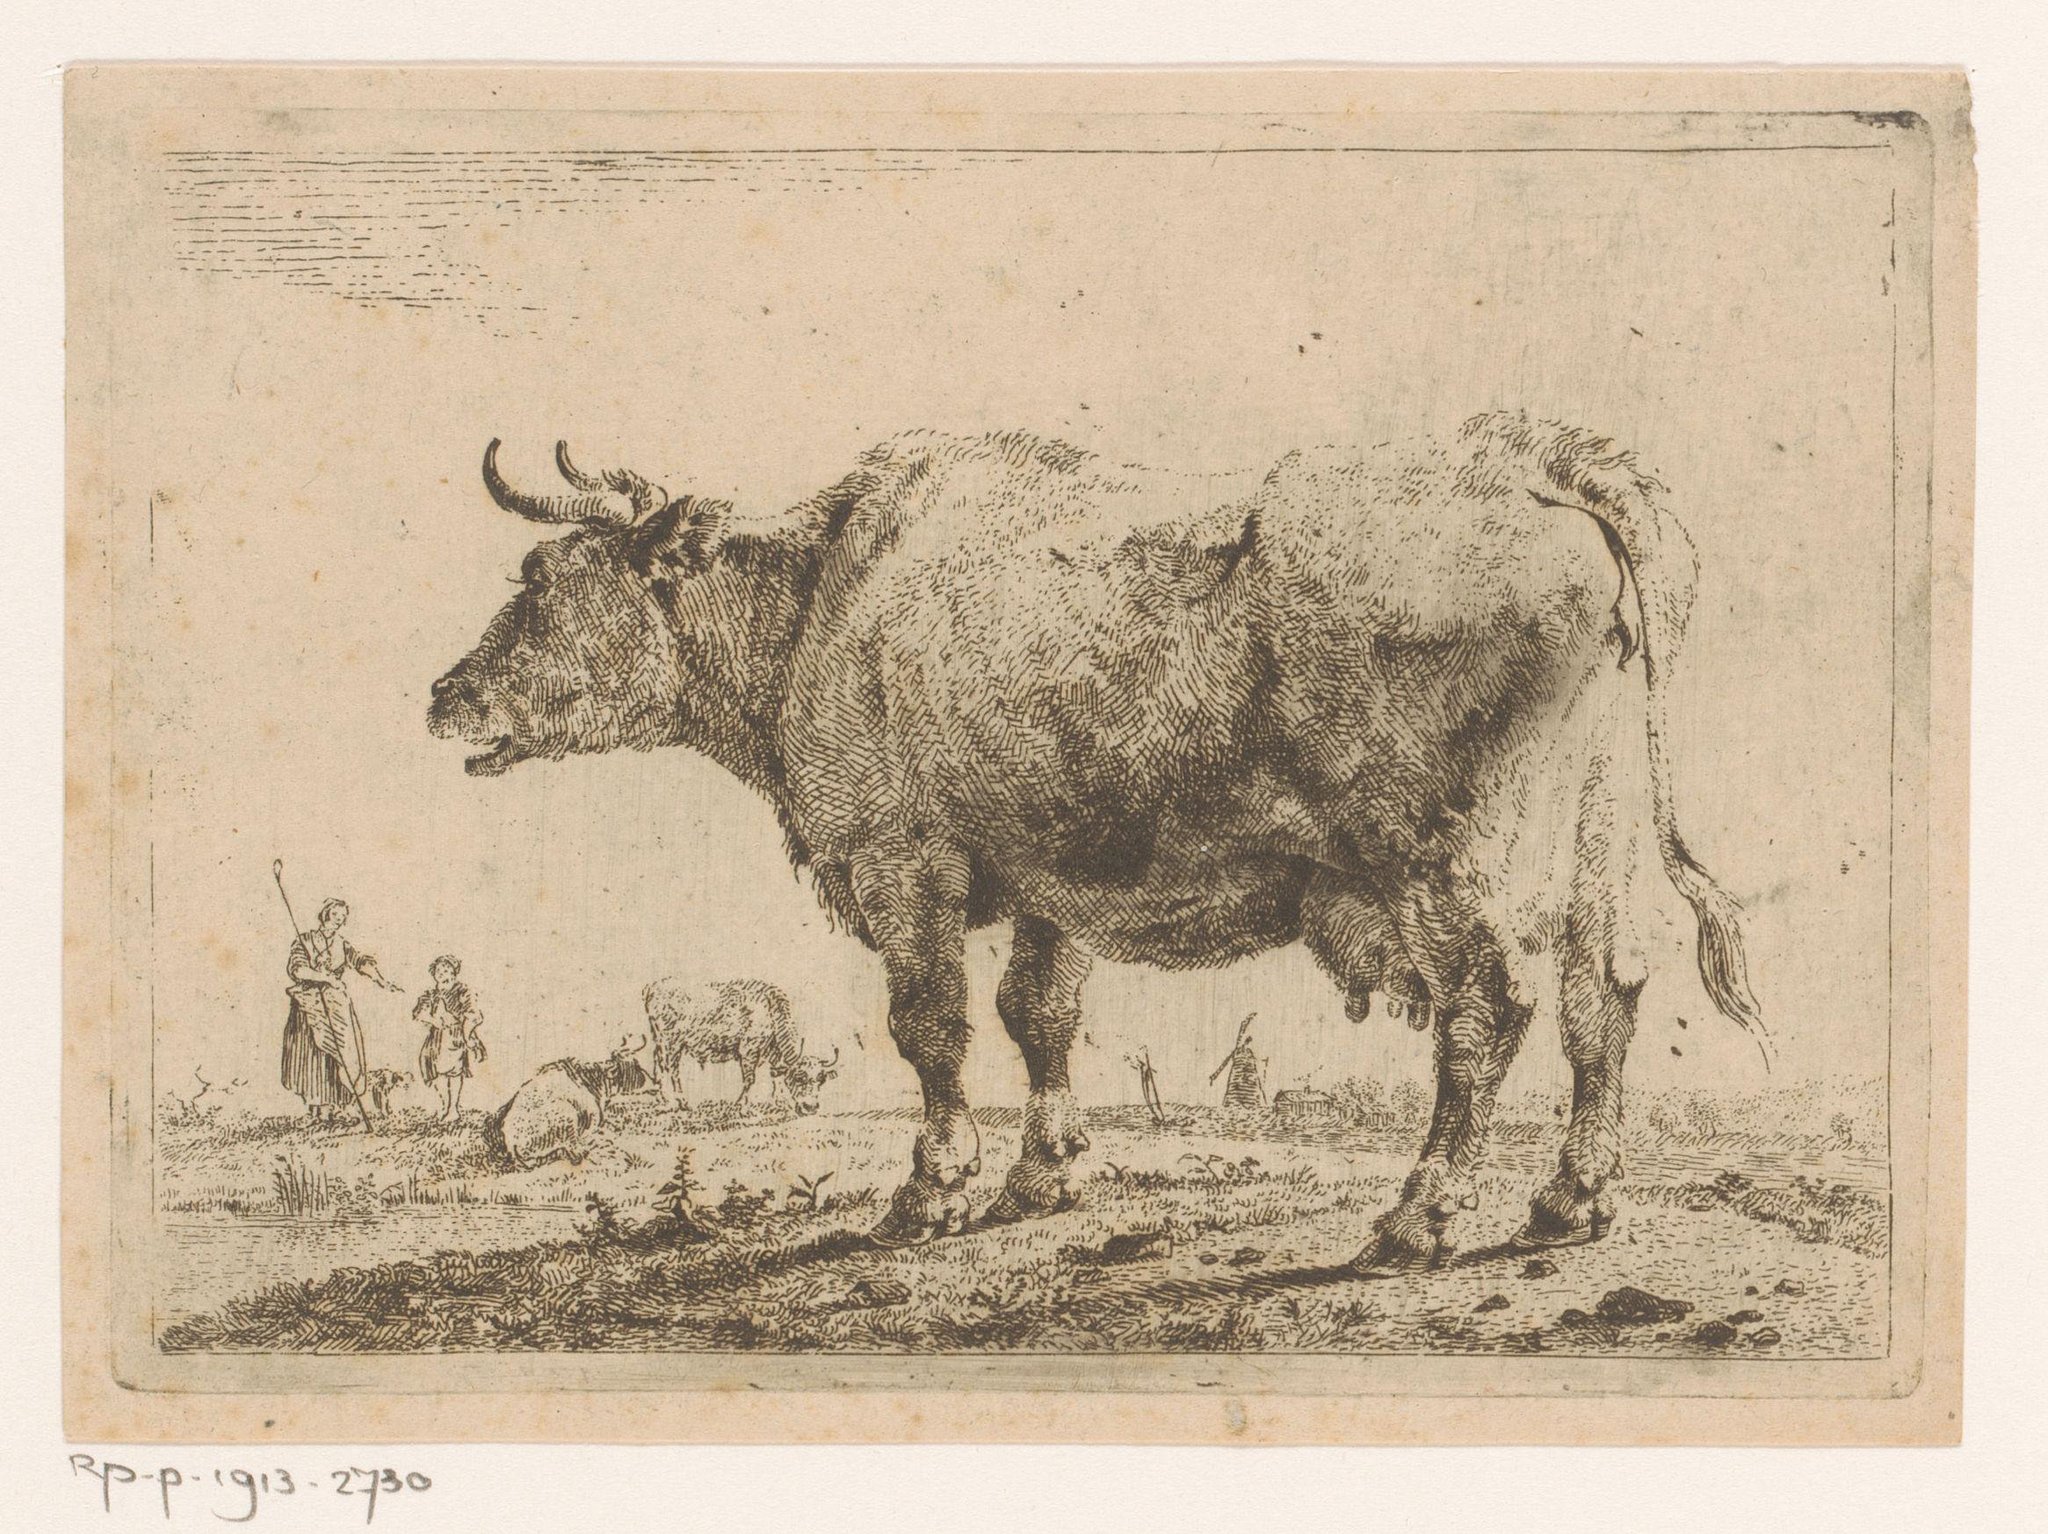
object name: print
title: Landschap met loeiende koe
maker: jean baptiste de roy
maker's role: print maker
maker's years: 1759-1839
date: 1769-1839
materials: paper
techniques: etching, intaglio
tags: cow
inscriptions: collector's mark: Lugt 1485, collector's mark: Lugt 2228